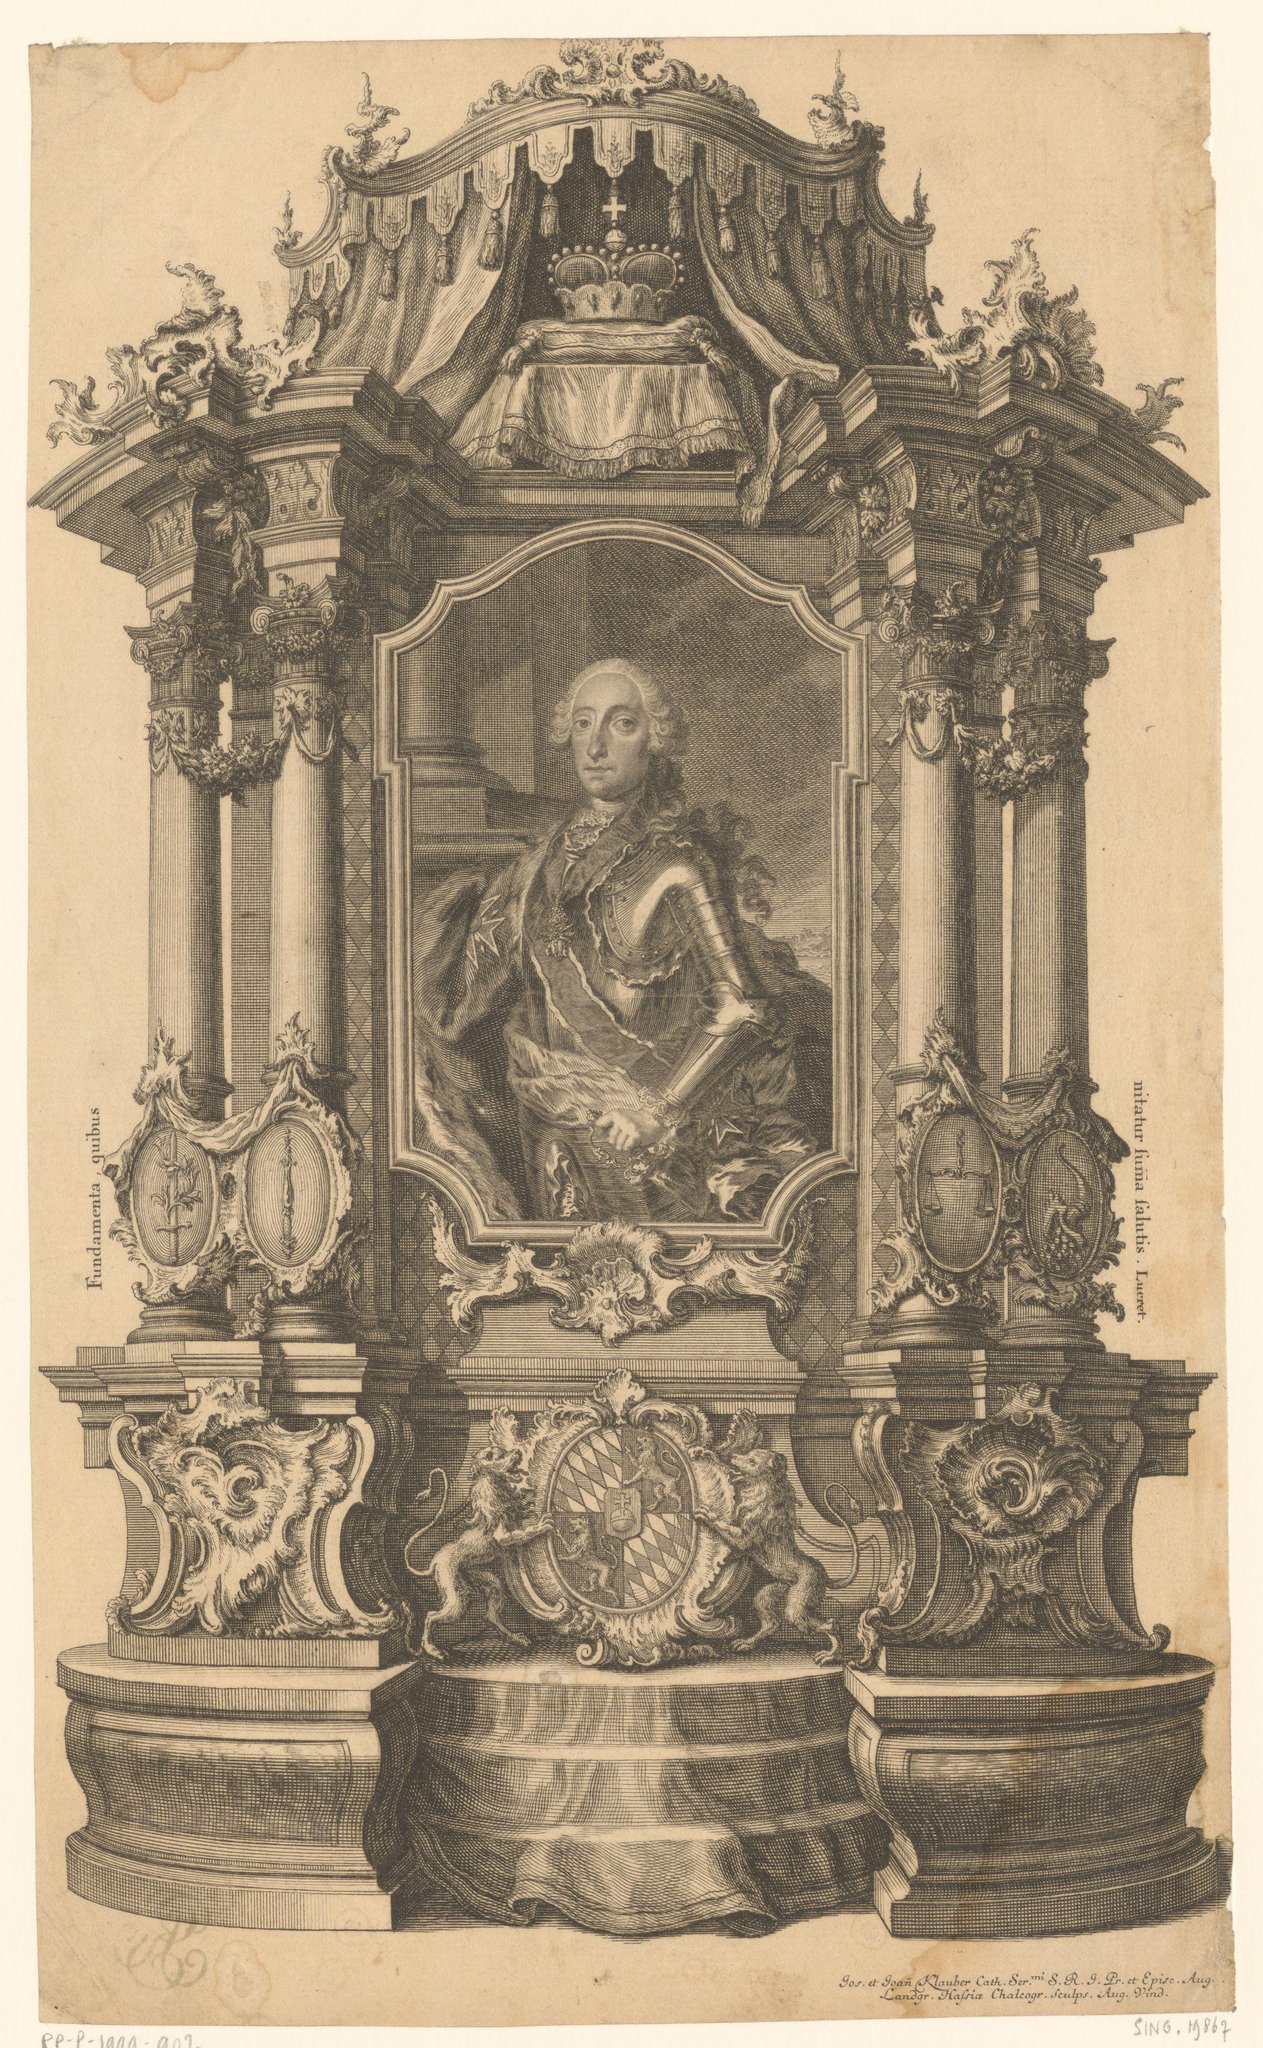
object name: print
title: Portret van Maximiliaan III Jozef van Beieren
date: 1722-1768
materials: paper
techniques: engraving, etching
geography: augsburg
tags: historical persons, ruler, sovereign, knighthood order of the golden fleece - insignia of a knighthood order, e.g.: badge, chain (with name of order), ornament derived from architectural details, armorial bearing, heraldry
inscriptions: collector's mark: Lugt 4099, collector's mark: Lugt 2760, collector's mark: Lugt 2228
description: Portret weergegeven als schilderij in ornamentale nis. Tekst in het Latijn in de marges.